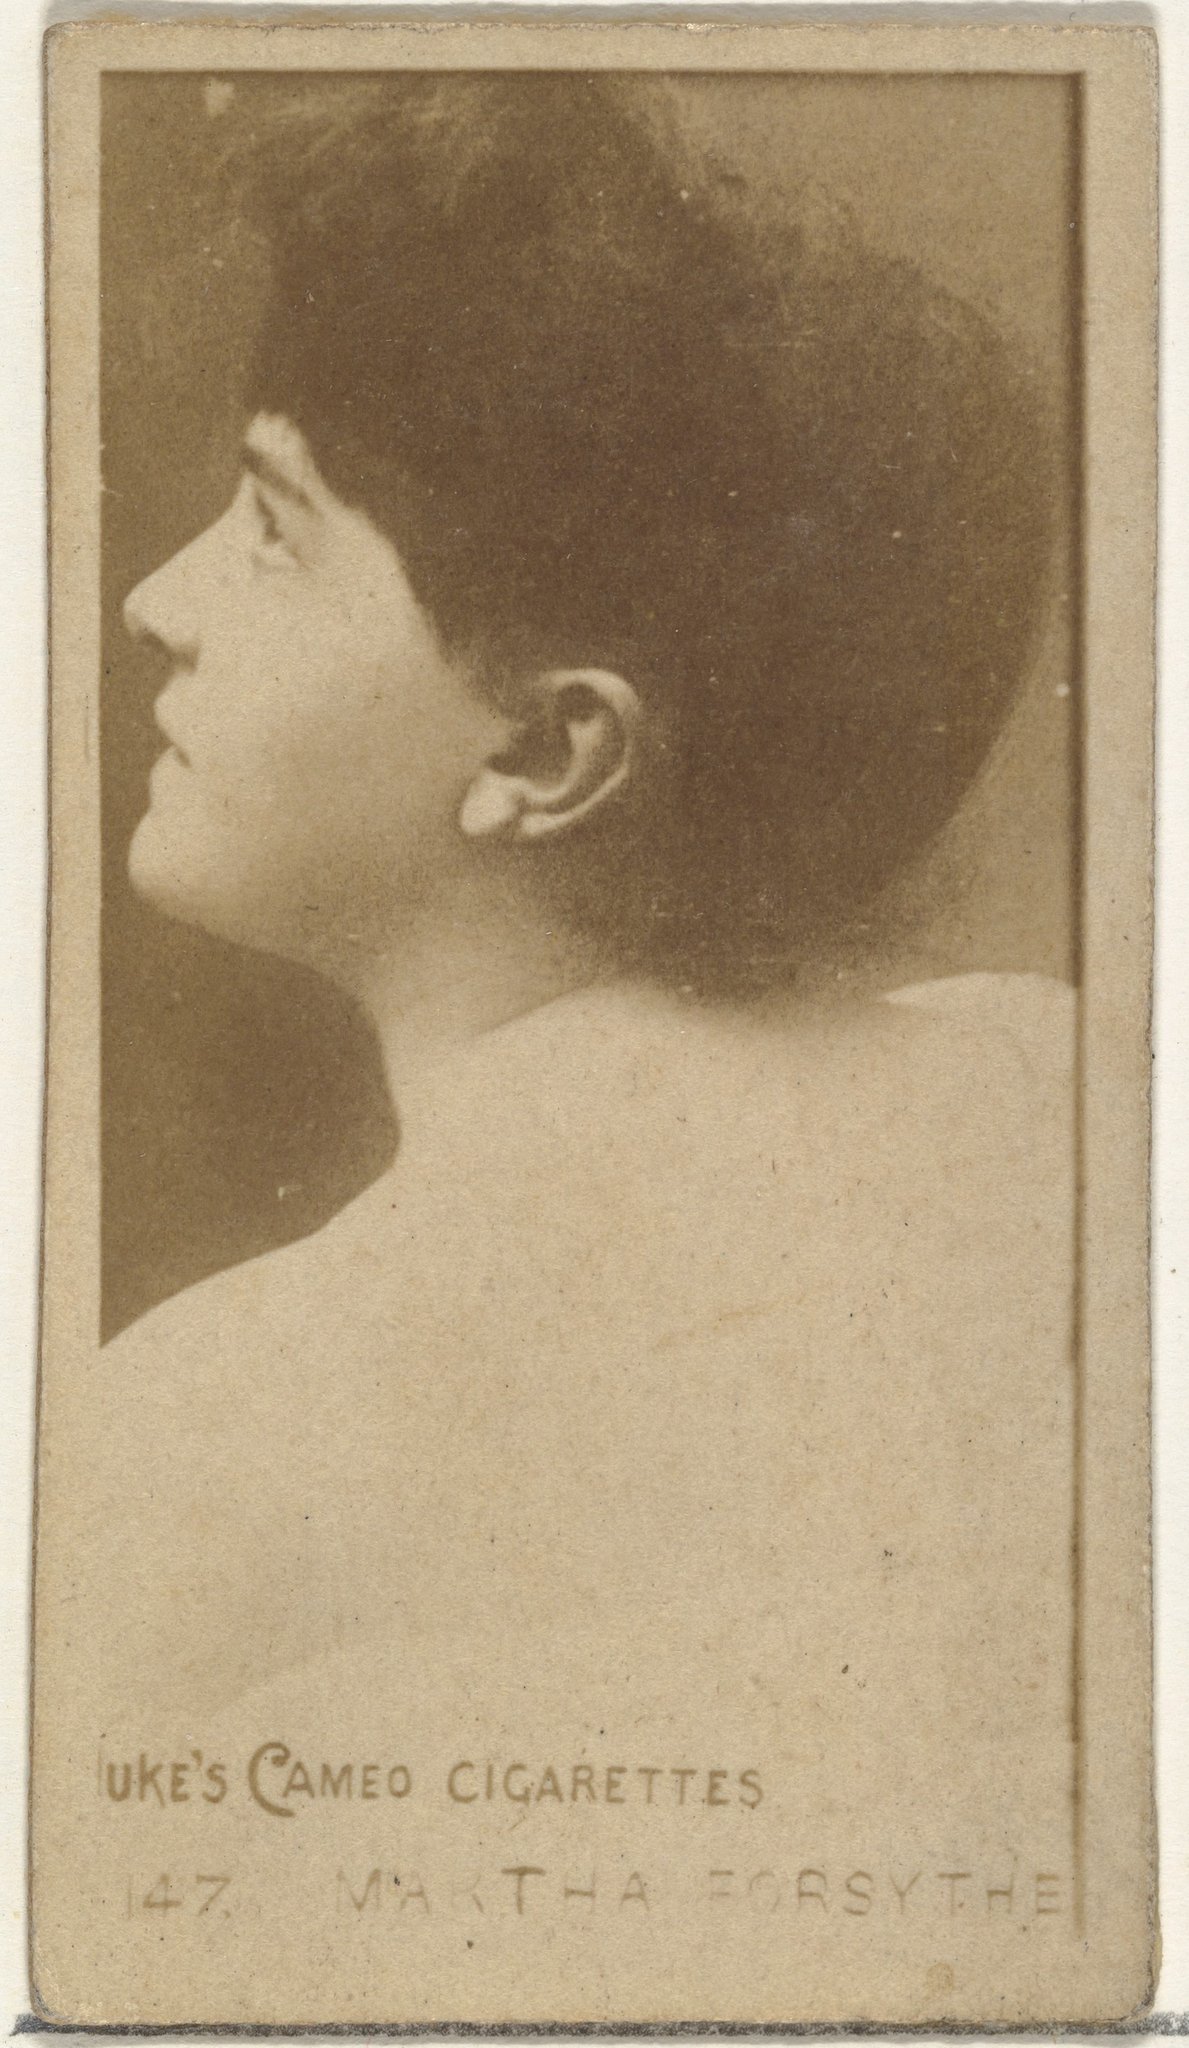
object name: photograph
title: Card Number 147, Martha Forsythe, from the Actors and Actresses series (N145-4) issued by Duke Sons & Co. to promote Cameo Cigarettes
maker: w. duke, sons & co.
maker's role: publisher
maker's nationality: american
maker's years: 1870-1920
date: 1880-1889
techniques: albumen silver print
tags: women,actresses